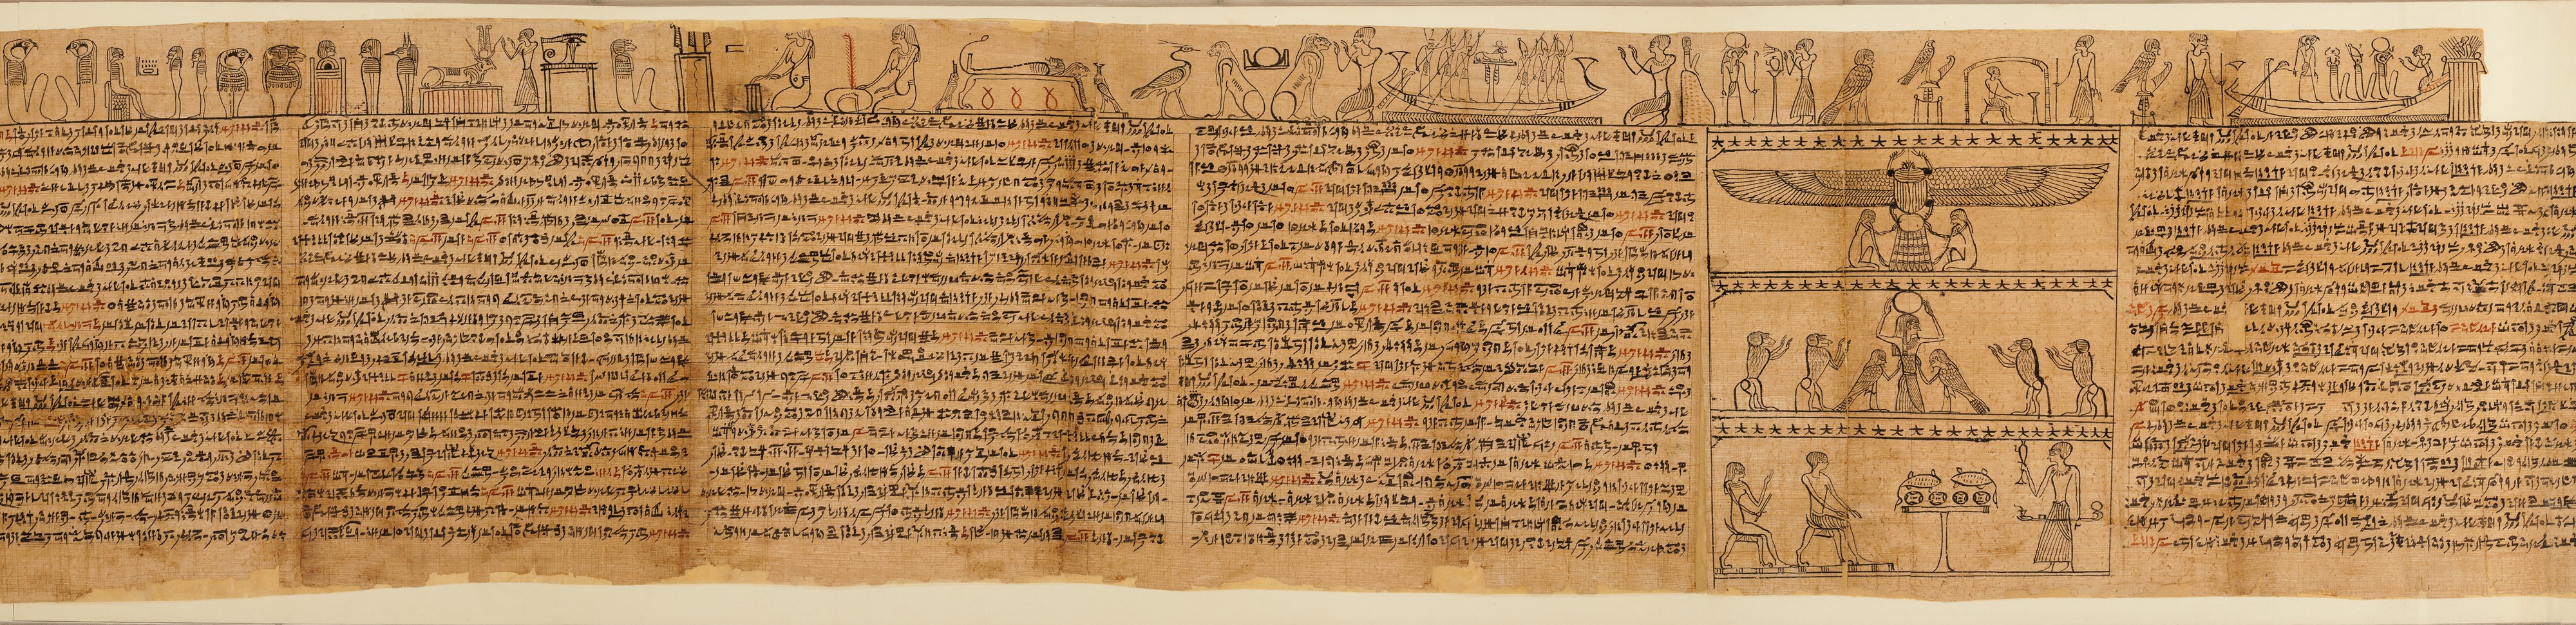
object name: papyrus, funerary, book of the dead, imouthes, imhotep, imuthes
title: Book of the Dead of the Priest of Horus, Imhotep (Imuthes)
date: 332-200 BCE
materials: ink, papyrus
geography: middle egypt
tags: birds,lions,boats,hieratic